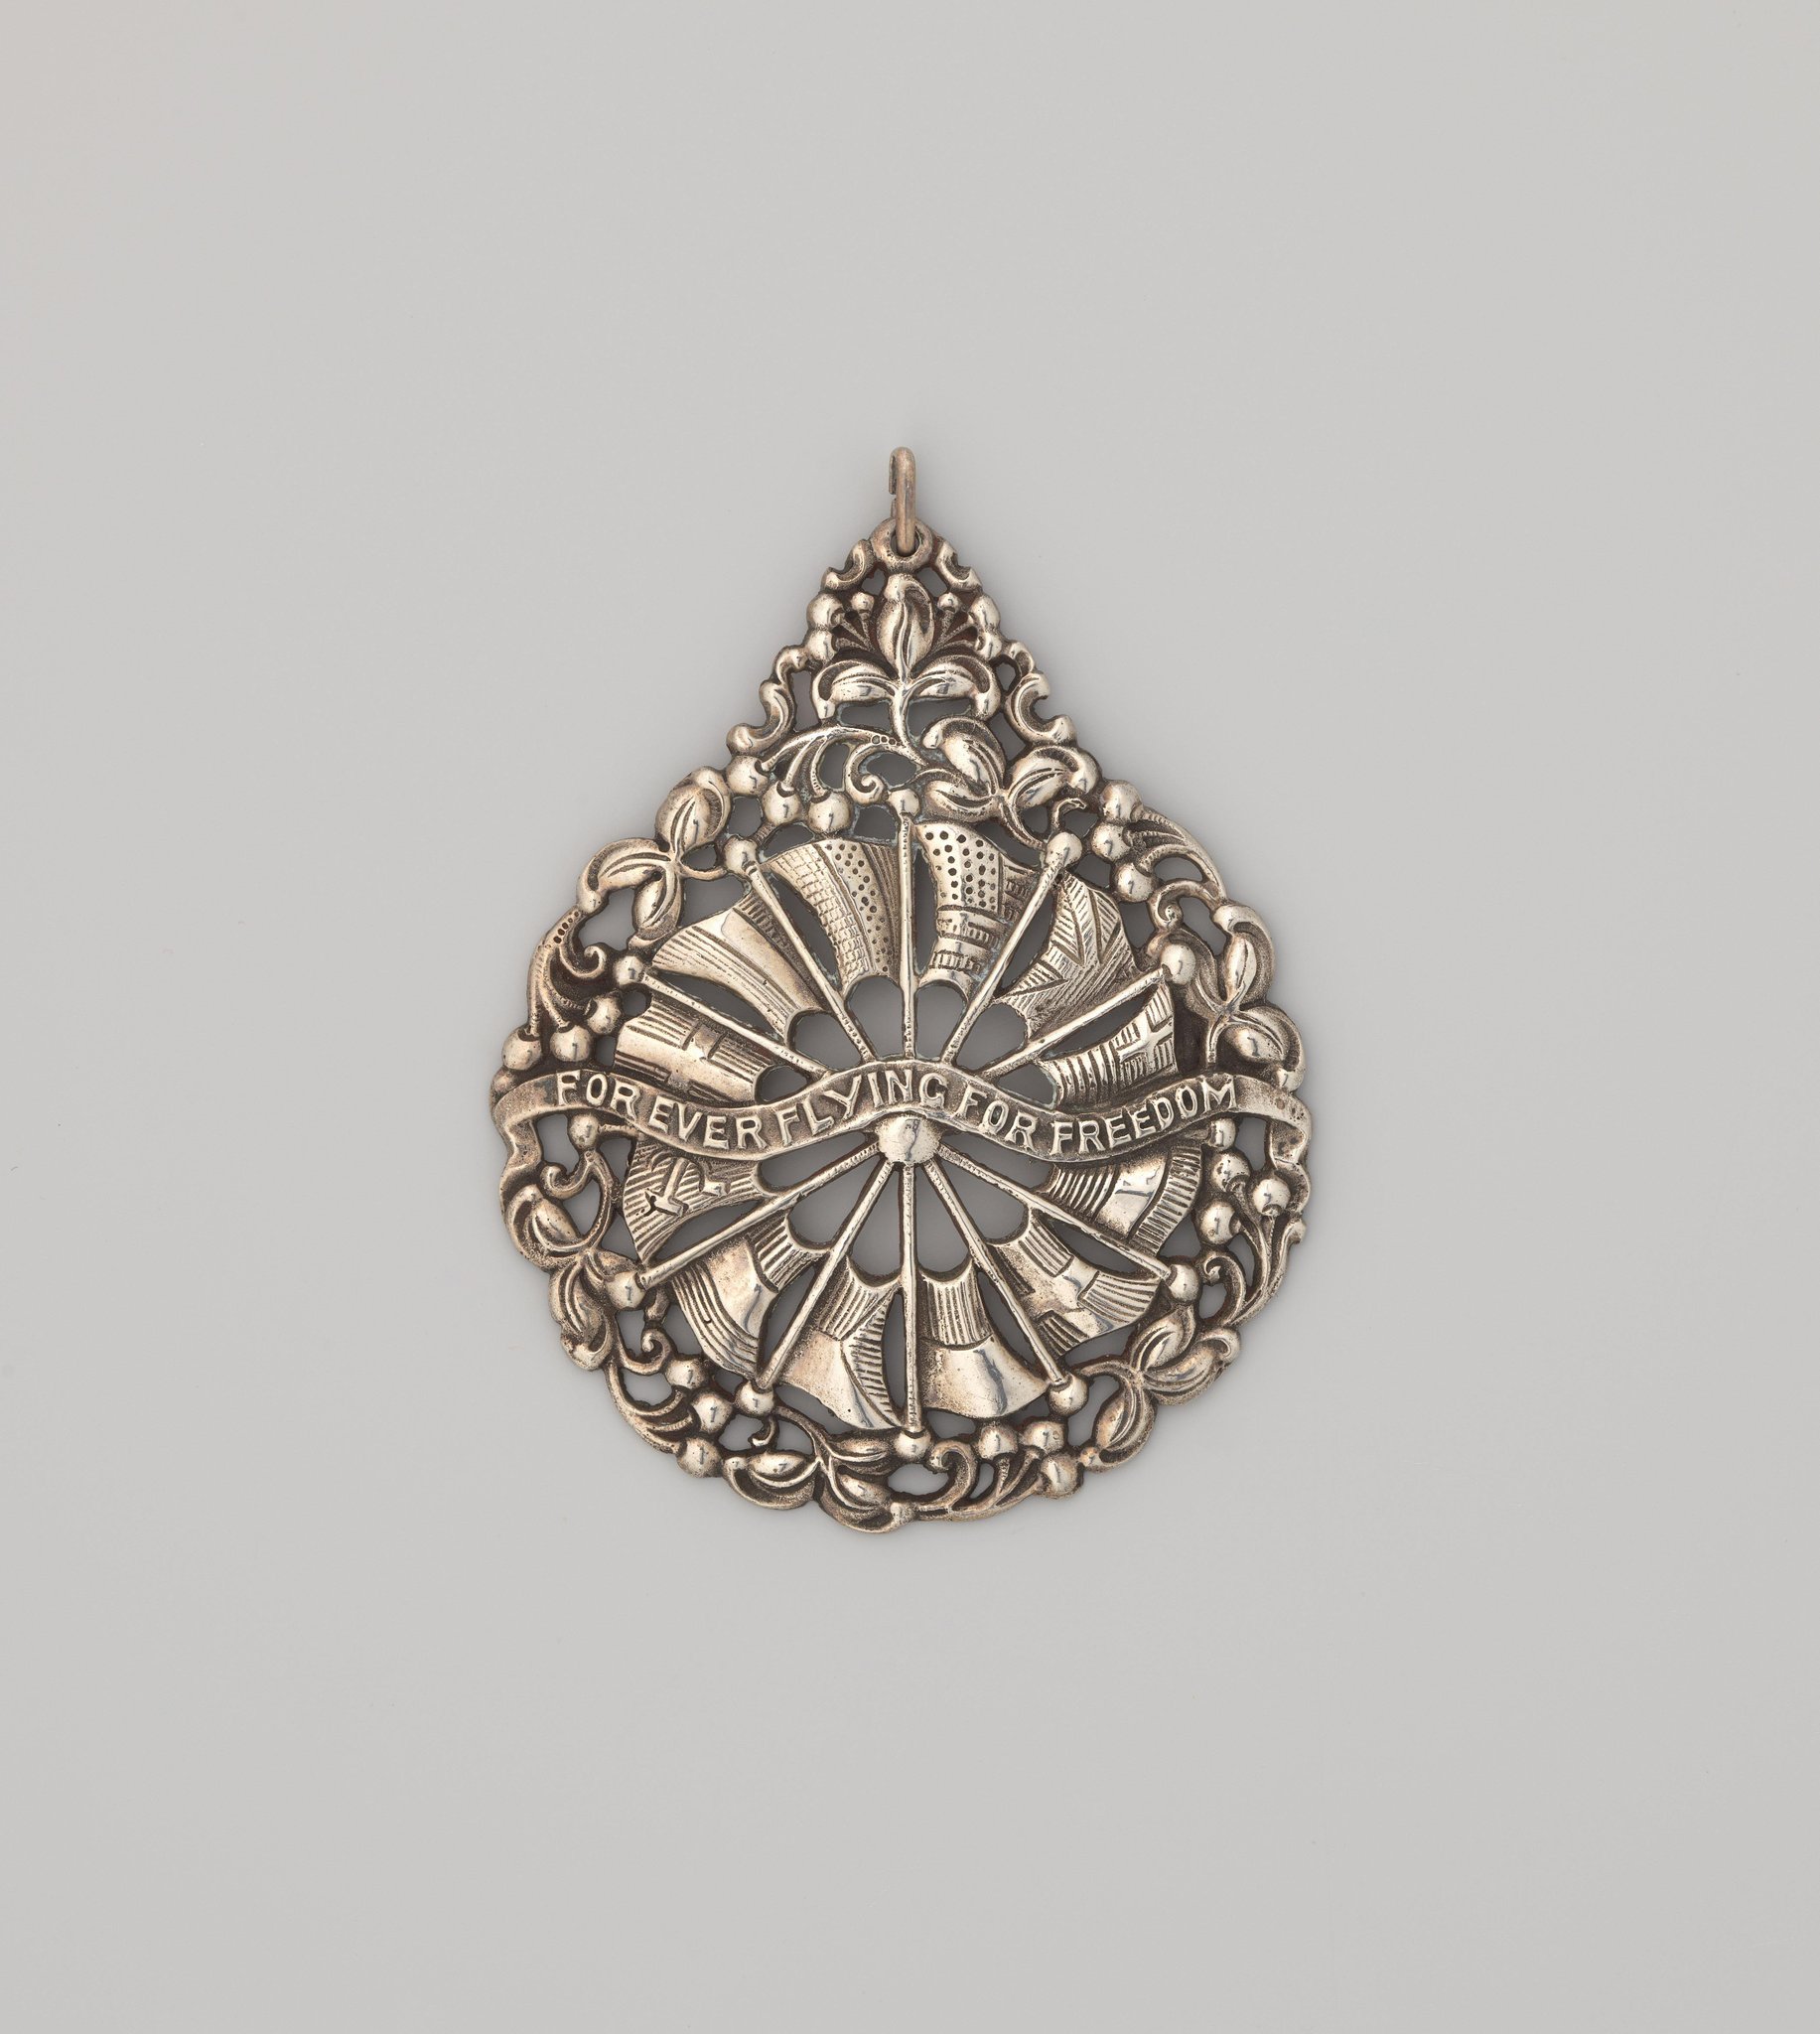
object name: pendant jewelry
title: For Ever Flying for Freedom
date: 1945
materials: silver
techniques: casting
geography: haarlem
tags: bevrijding tweede wereldoorlog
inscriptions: maker's mark: ‘WZV’, alloy mark: ‘oud zwaard’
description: Druppelvormige hanger van zilver met For Ever Flying for Freedom.